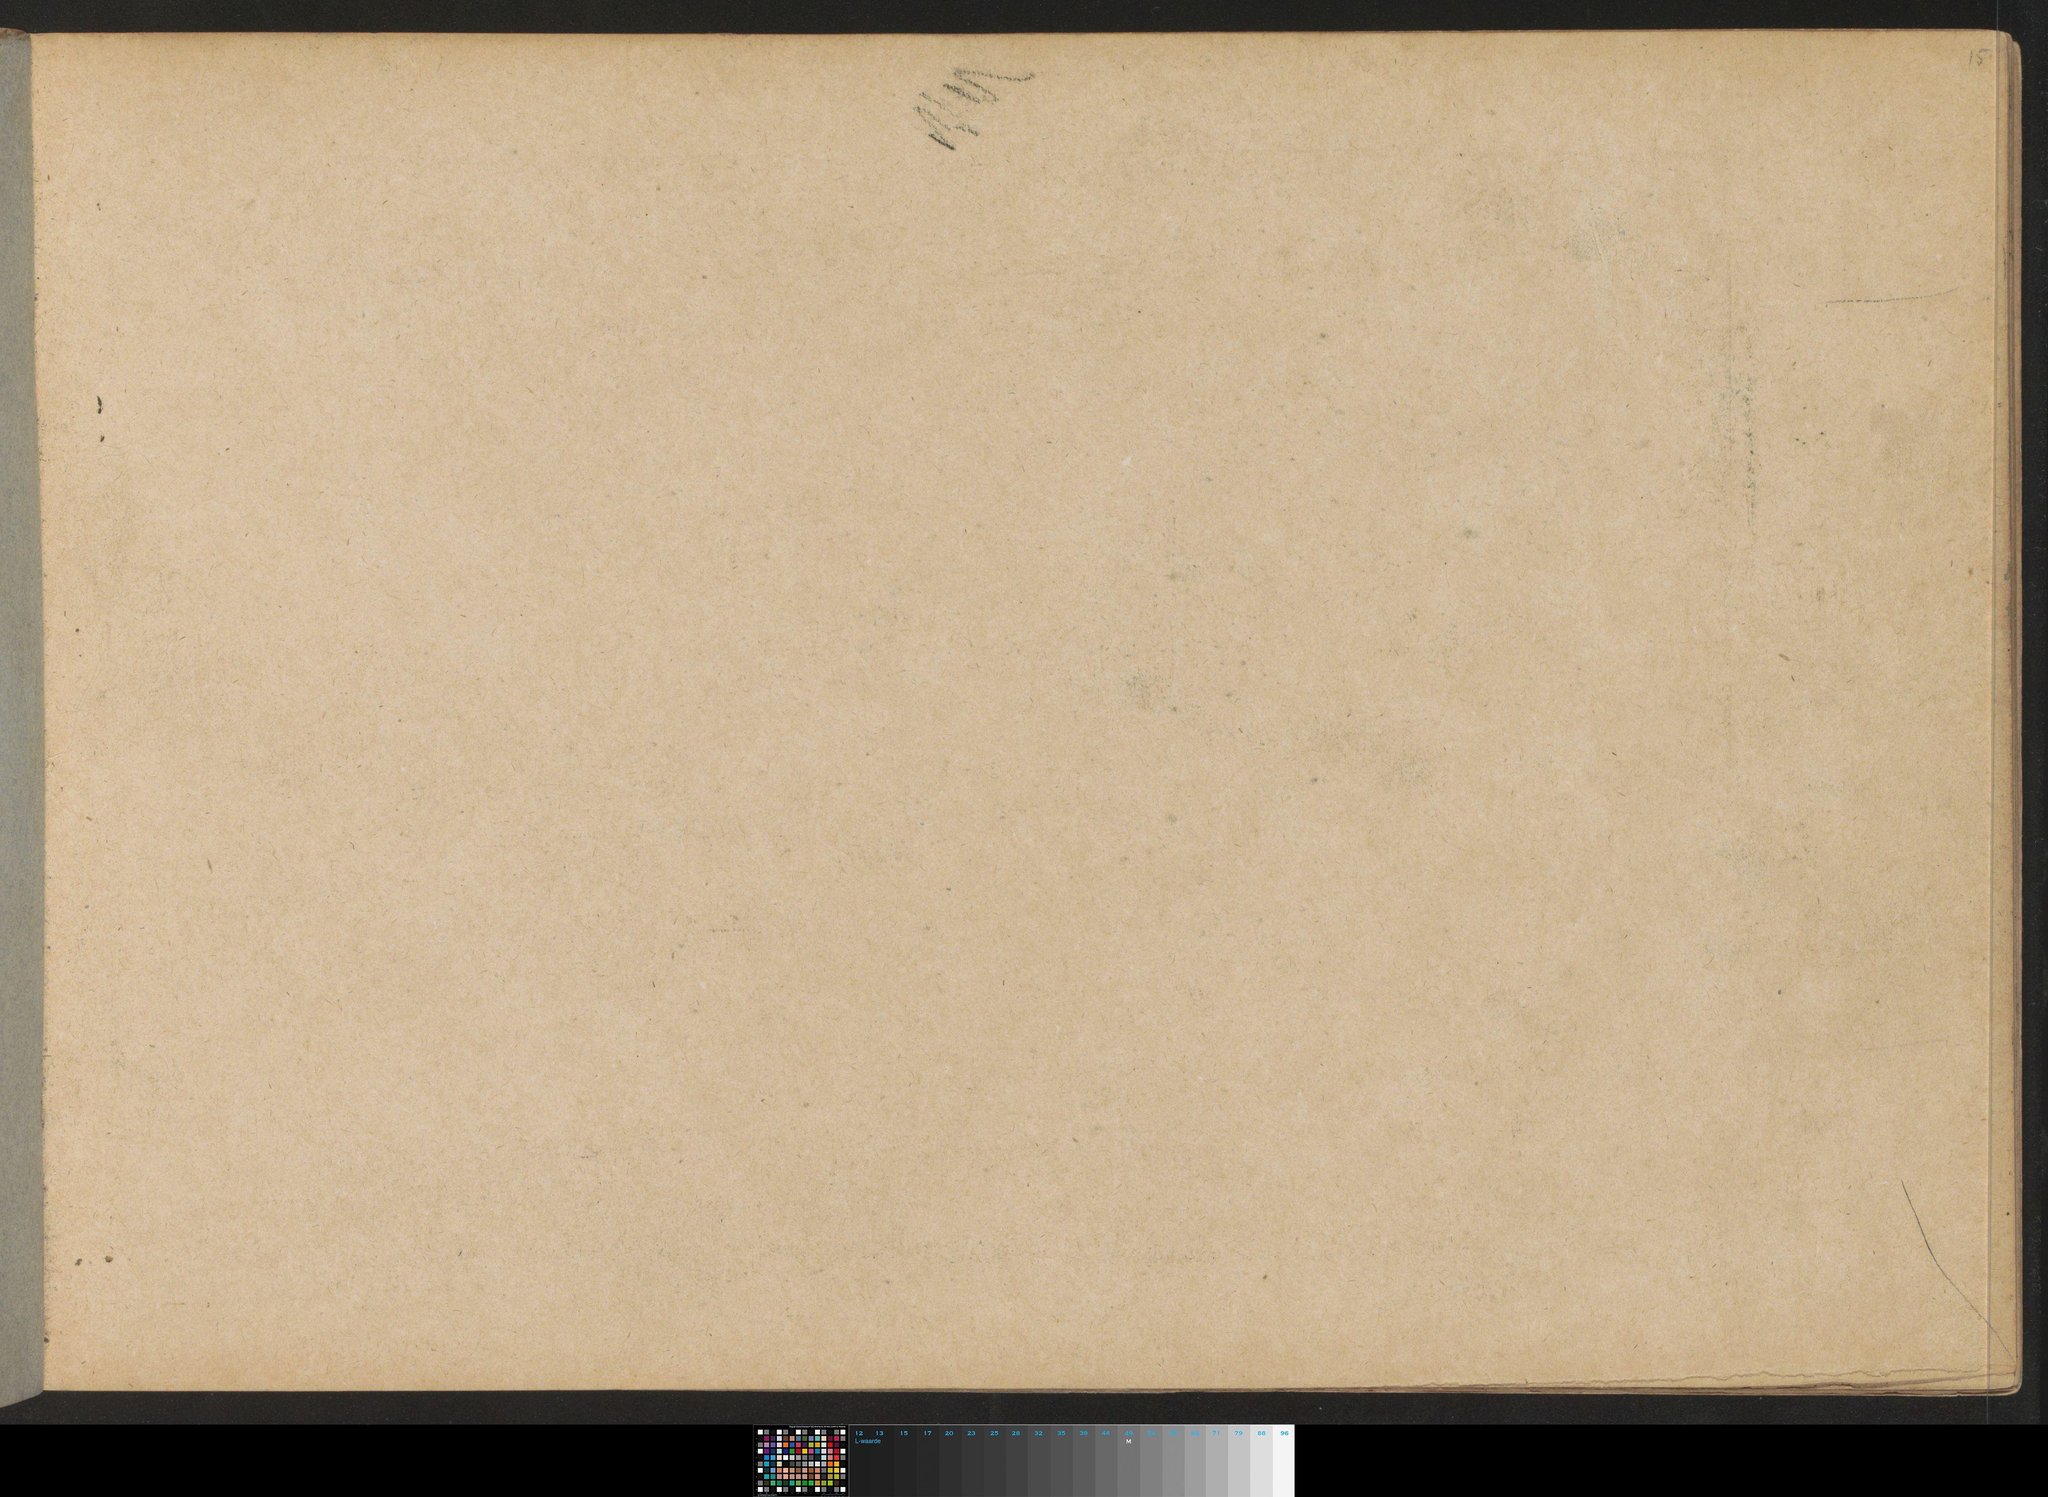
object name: sketchbook leaf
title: Studie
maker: willem witsen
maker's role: draughtsman, painter, print maker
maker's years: 1860-1923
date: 1882-1884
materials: chalk, paper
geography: ewijkshoeve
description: Pagina 15 uit een schetsboek met 19 bladen.